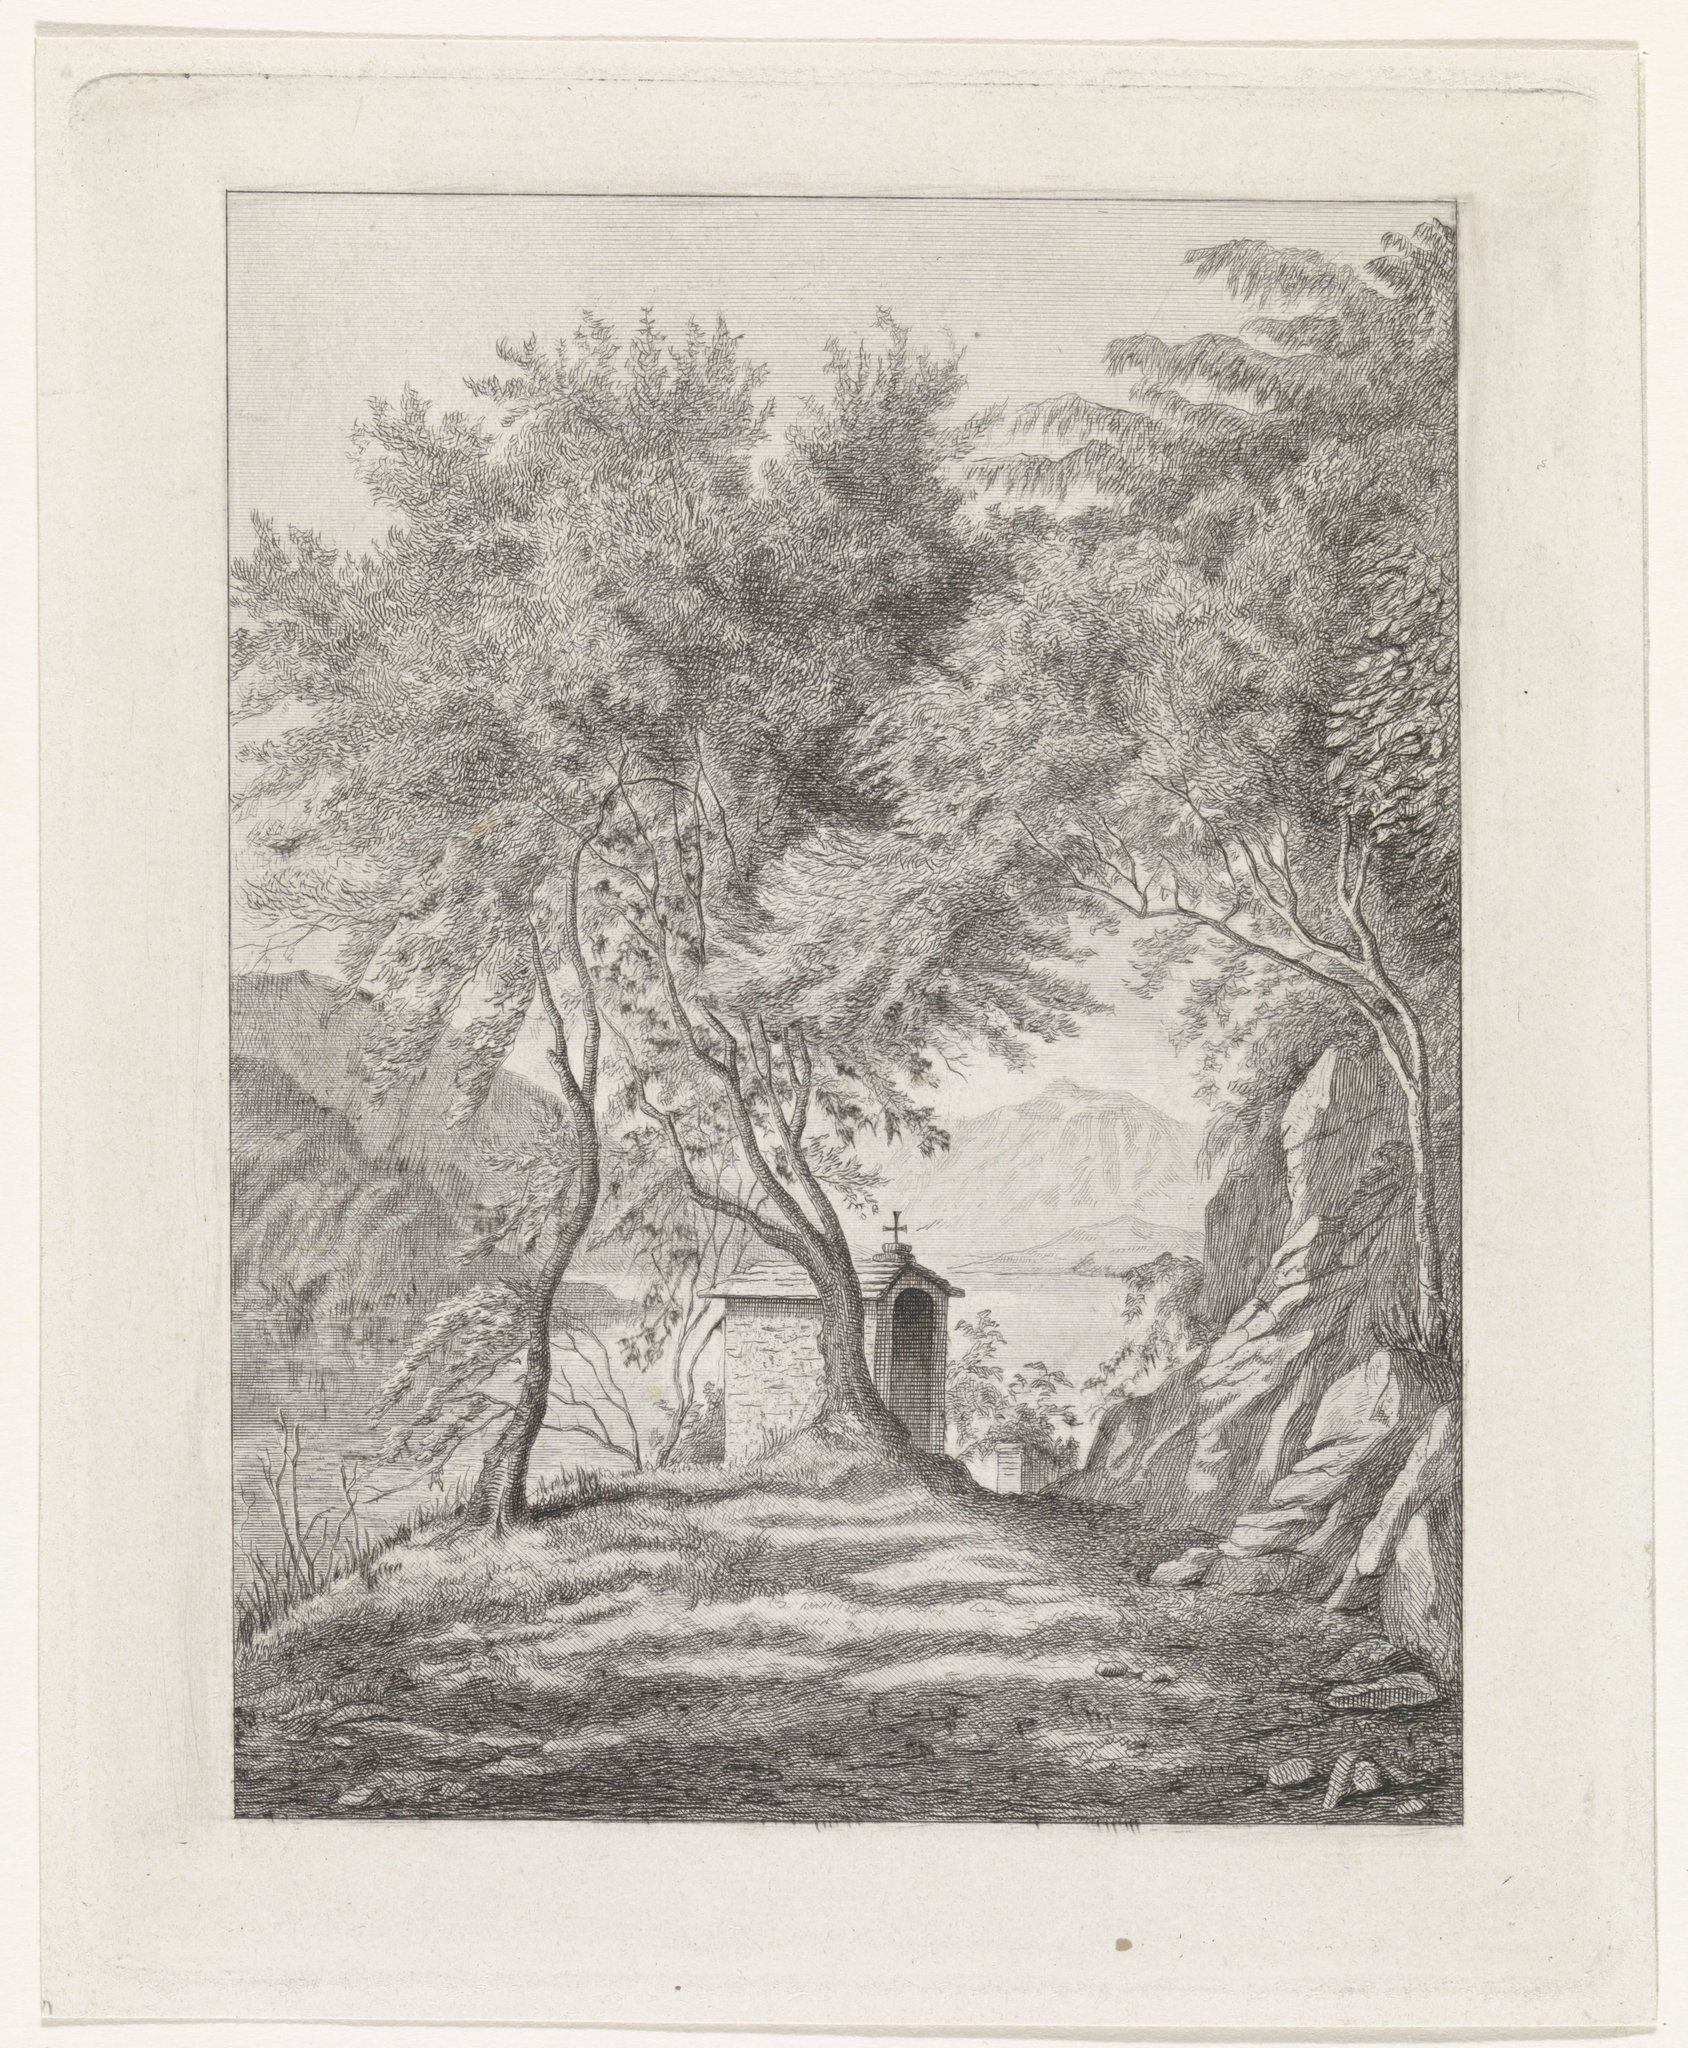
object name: print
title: Gezicht op het Comomeer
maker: david van der kellen (1827-1895)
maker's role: draughtsman, print maker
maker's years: 1827-1895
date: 1837-1882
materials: paper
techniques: etching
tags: church (exterior) - qq - small church, chapel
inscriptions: collector's mark: Lugt 2228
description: Gezicht op het Comomeer vanaf een heuvel met bomen en een kleine kapel. Rechts een deel van een rotspartij. Achter het Comomeer zijn contouren van bergen te zien.